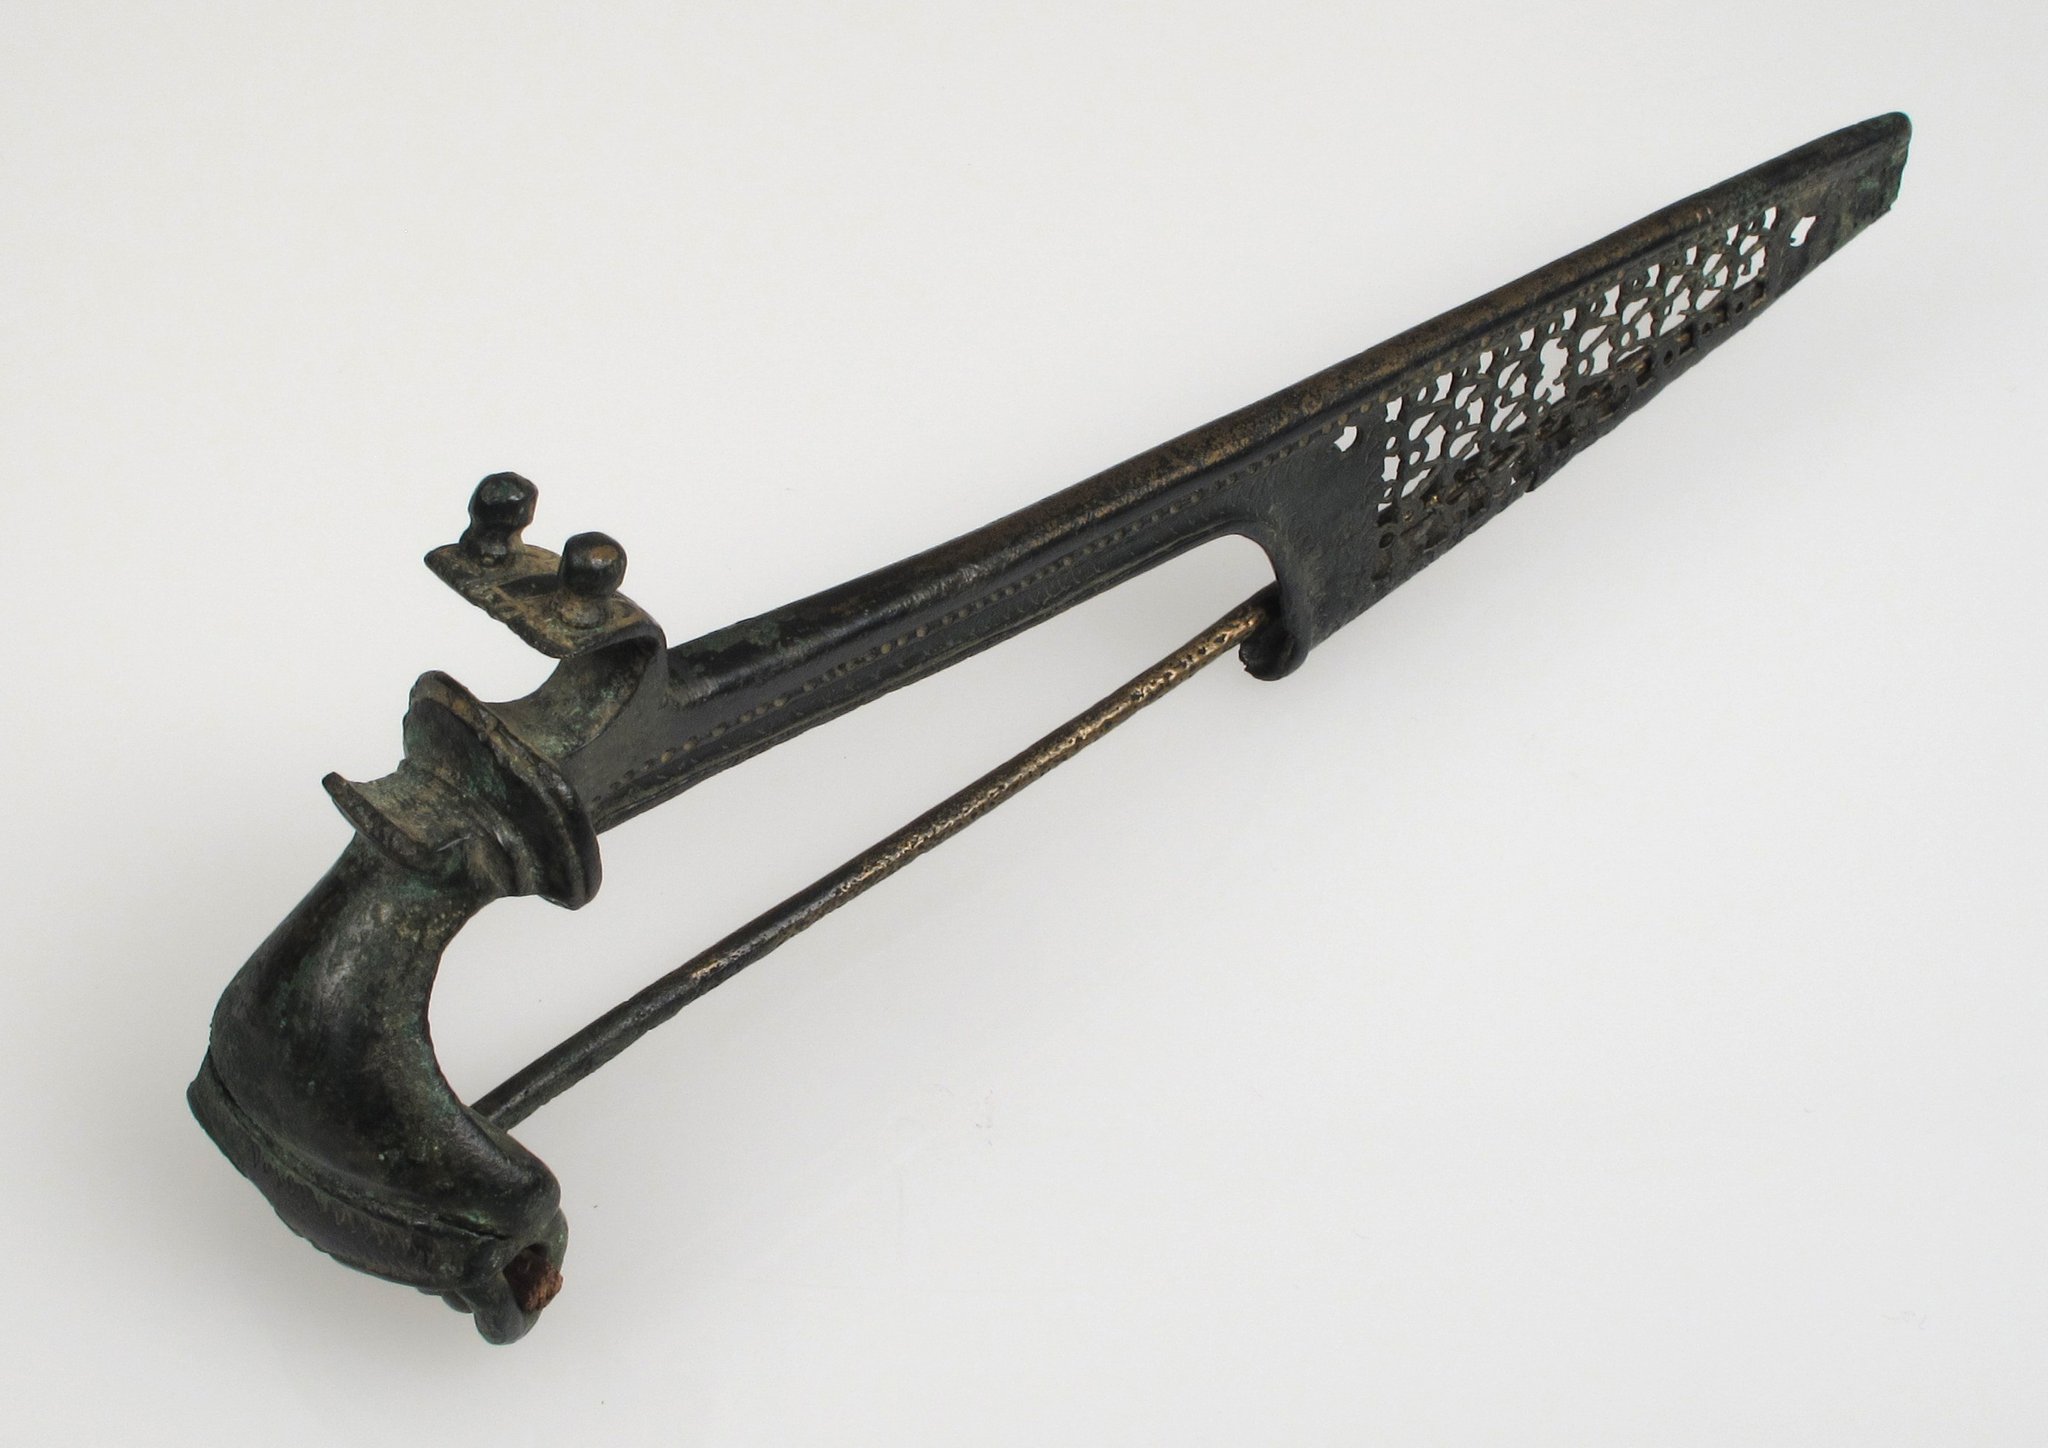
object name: brooch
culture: celtic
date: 100 BCE-100 CE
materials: copper alloy